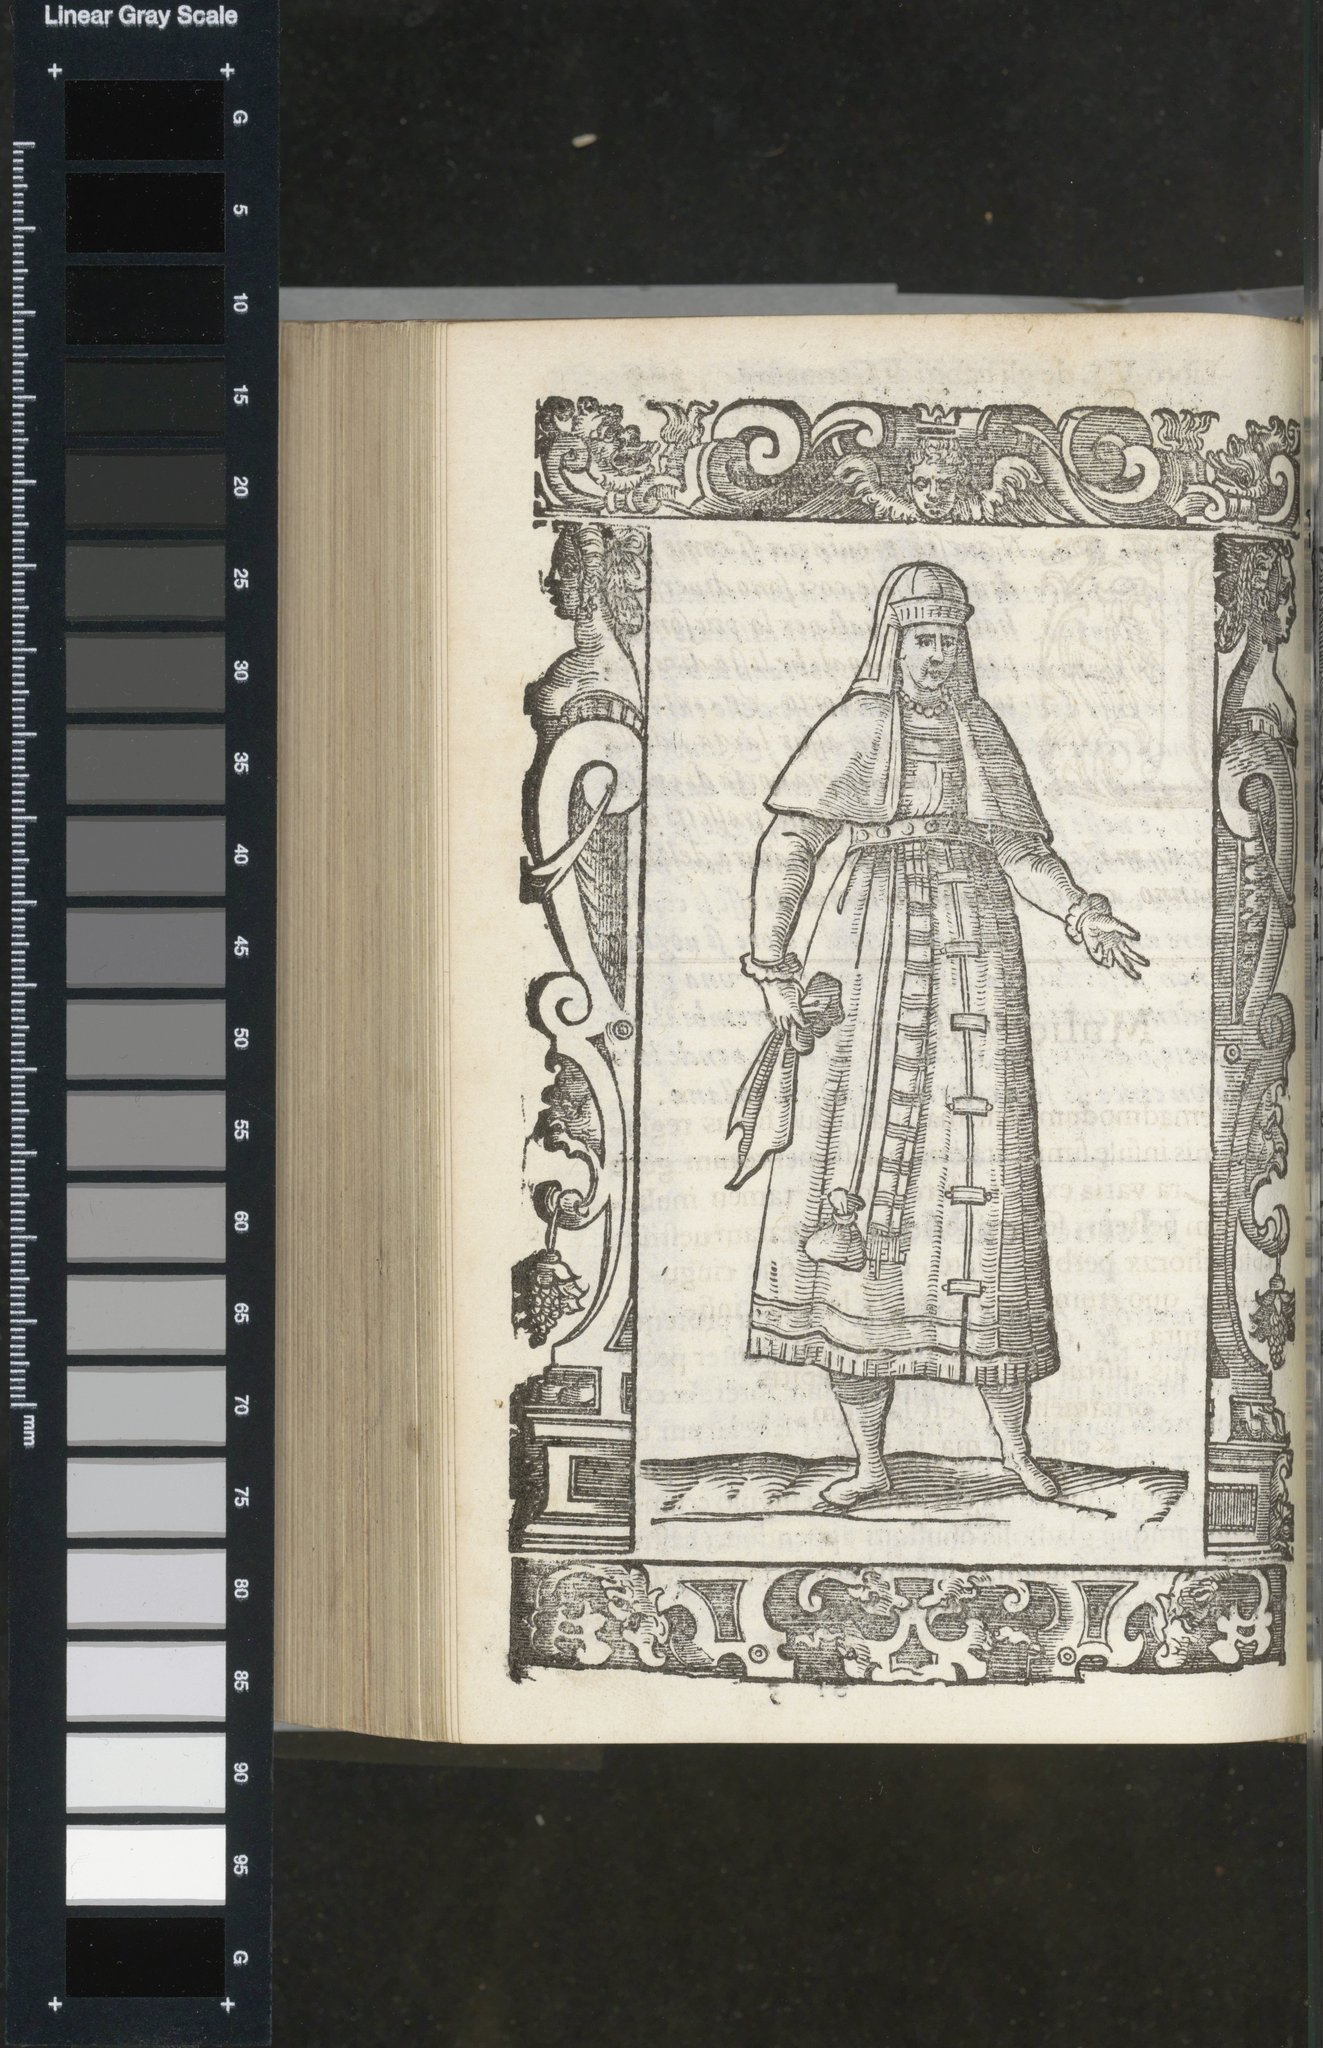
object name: costume print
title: Donna di Alfatia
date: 1598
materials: paper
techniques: woodcut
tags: fashion plates